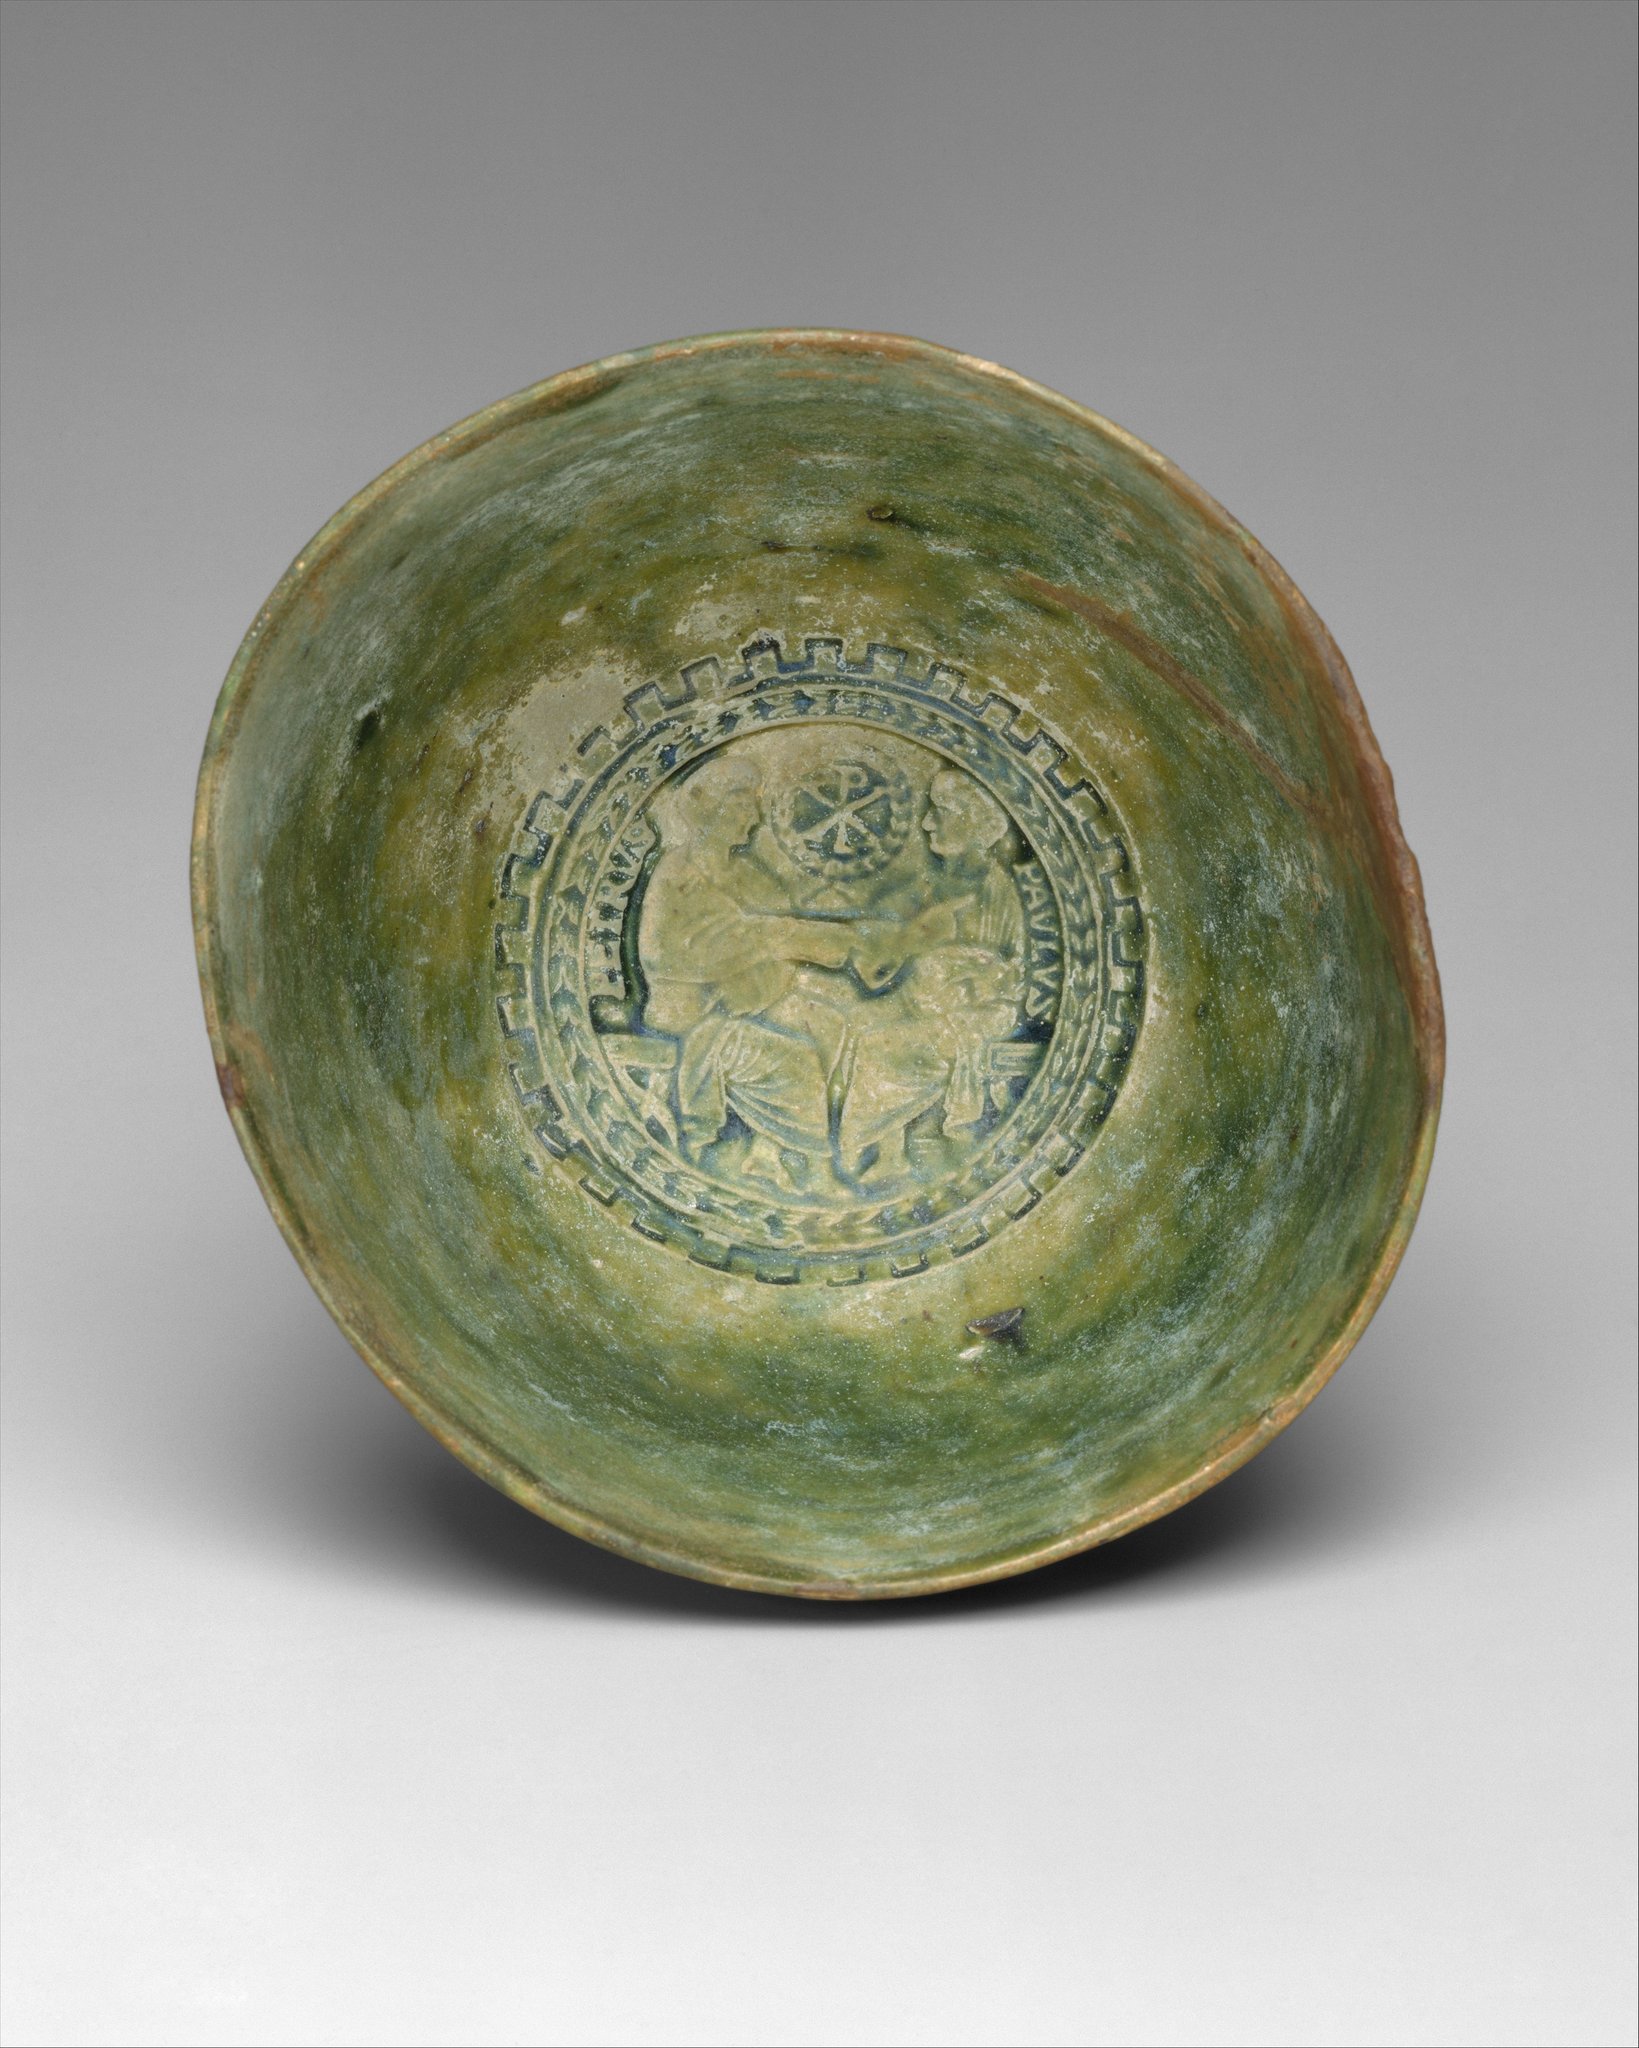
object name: bowl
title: Bowl with Saints Peter and Paul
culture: byzantine or roman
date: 350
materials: earthenware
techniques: glazing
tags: saint paul,saint peter